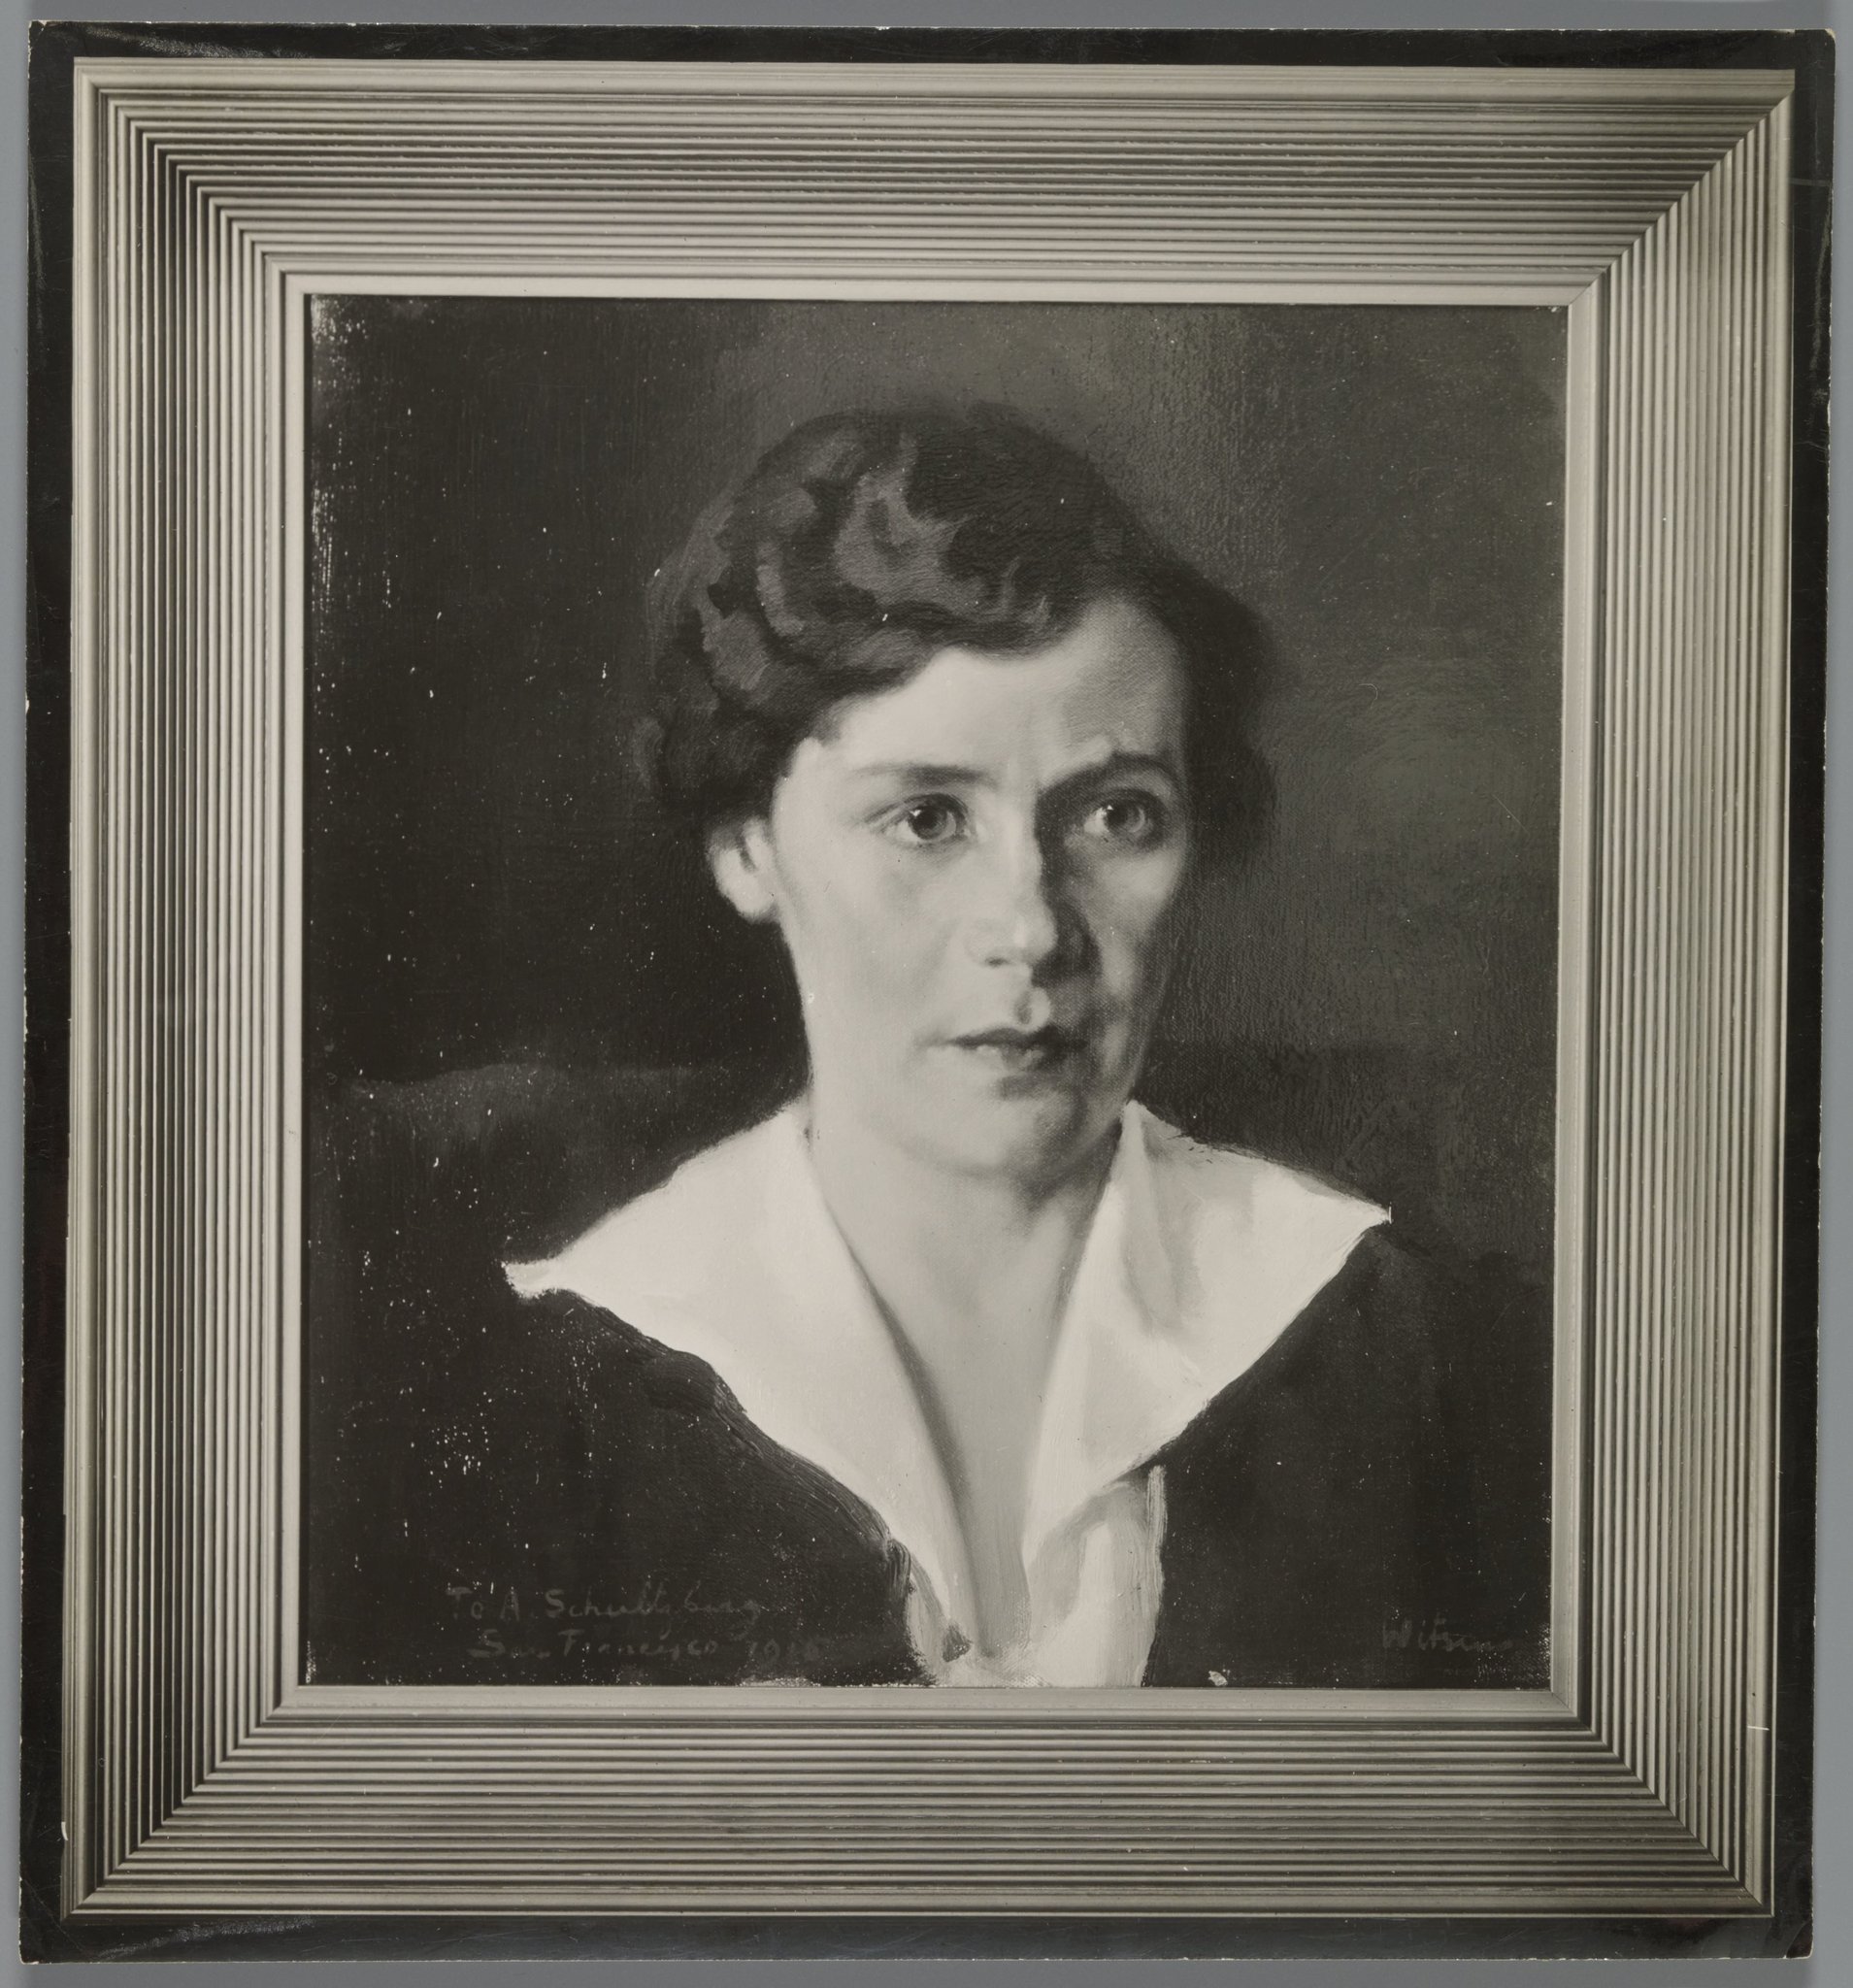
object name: photograph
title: Reproductie naar schilderij van Willem Witsen van een portret van mevrouw A. Schultzberg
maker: Anonymous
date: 1860-1915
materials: paper, photographic support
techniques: gelatin silver print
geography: netherlands